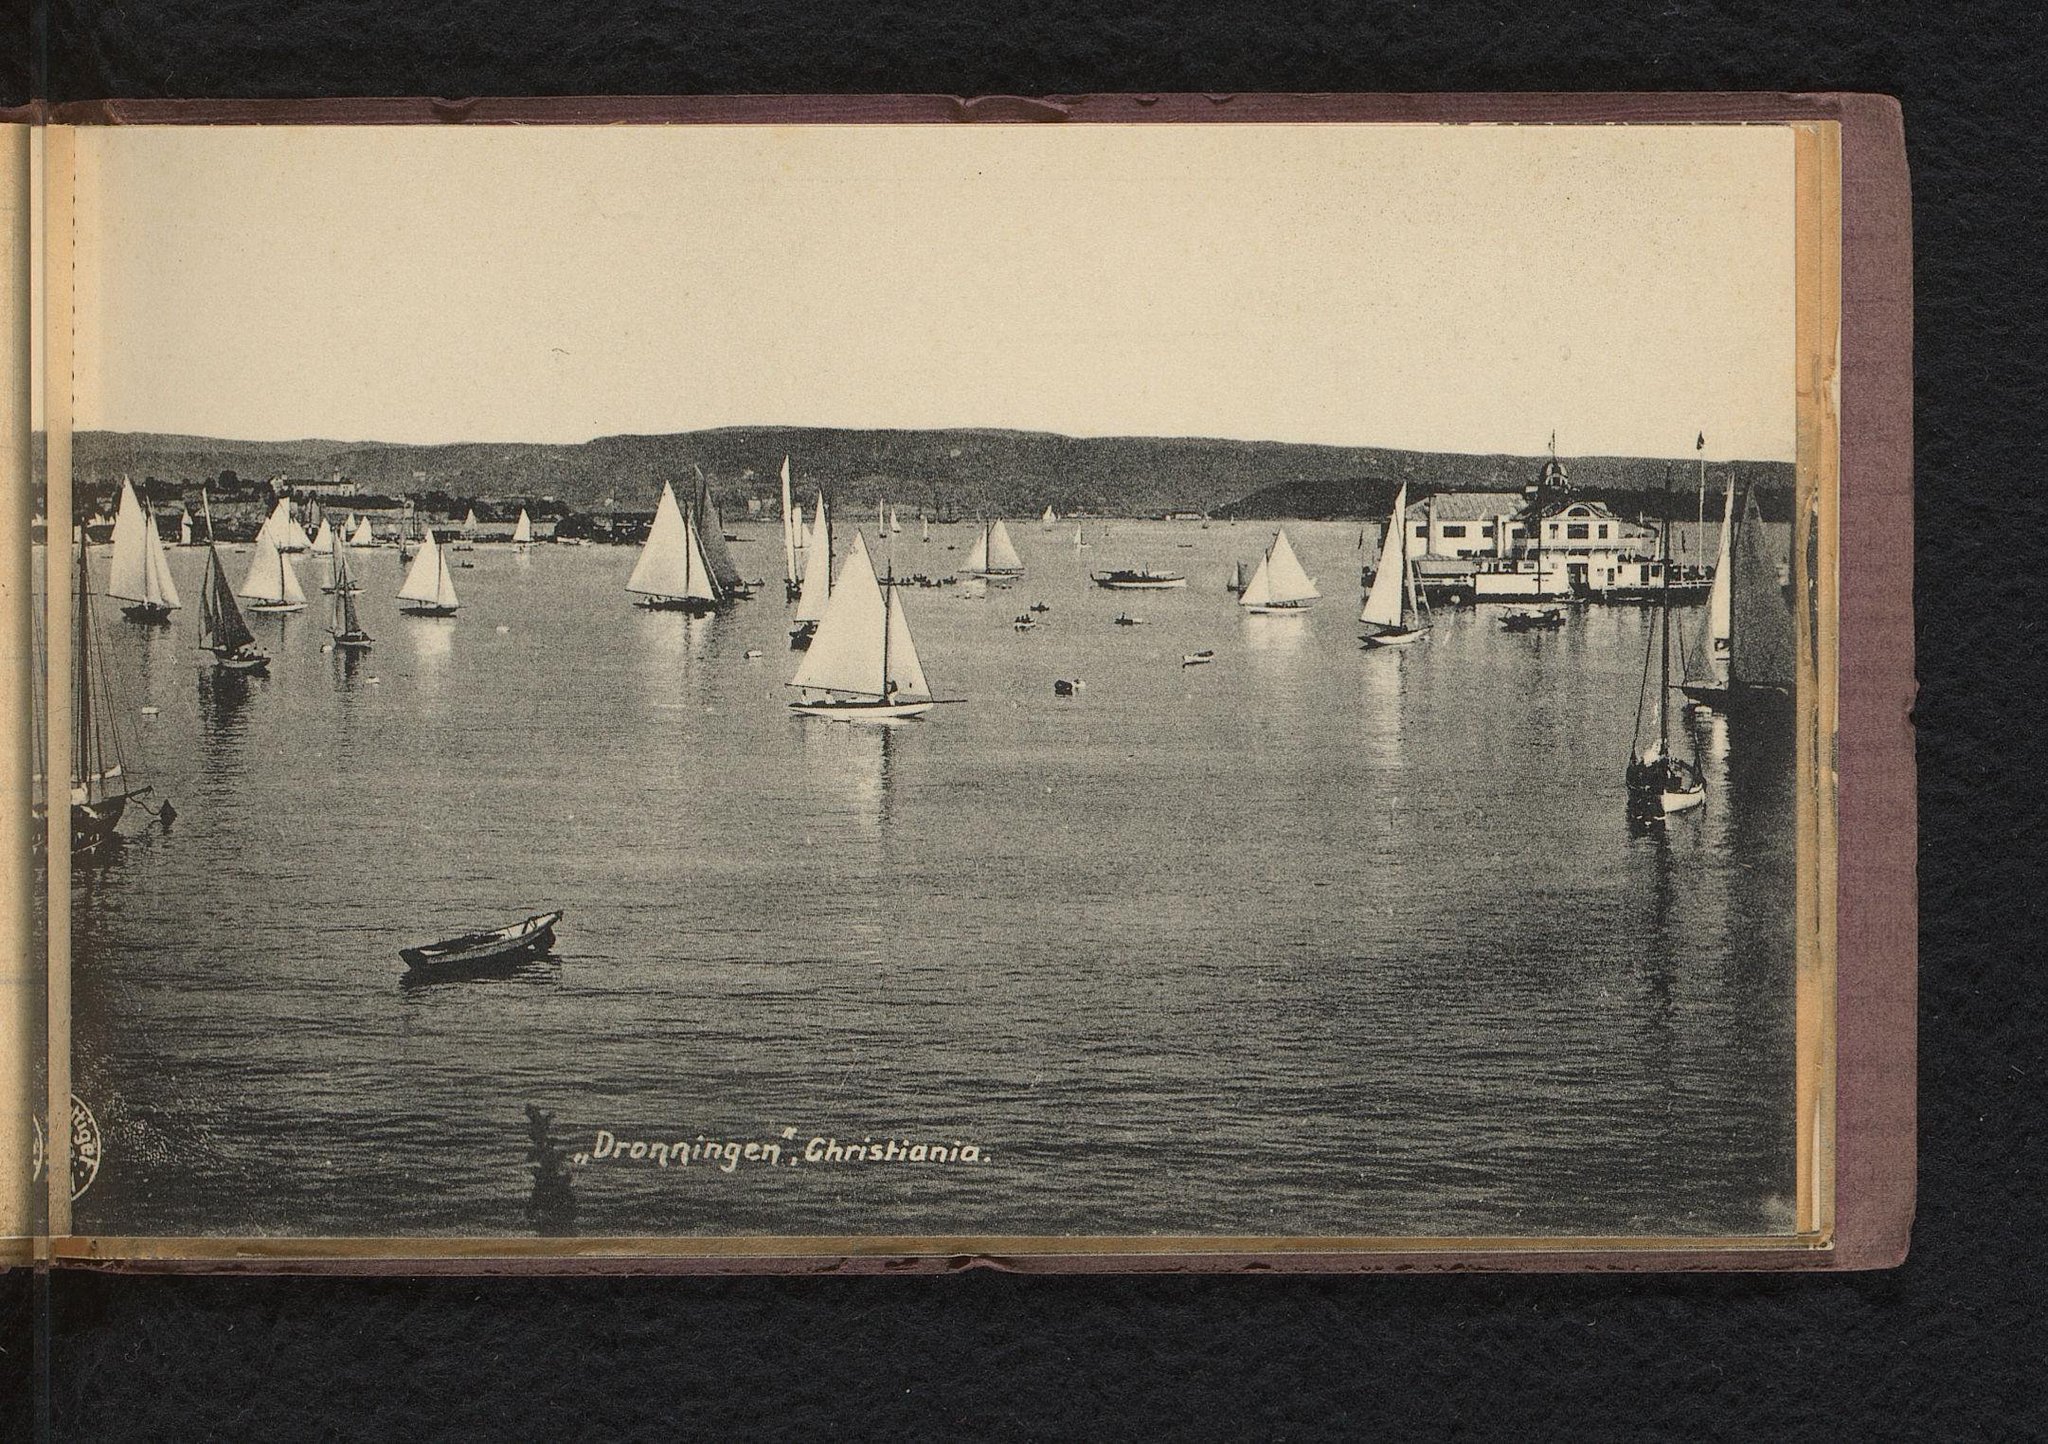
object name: photomechanical print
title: "Dronningen", Christiania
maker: Anonymous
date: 1904-1925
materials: cardboard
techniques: photograph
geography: oslo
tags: sailing-ship, sailing-boat, fjord, sea loch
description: Prentbriefkaart maakt deel uit van een album.